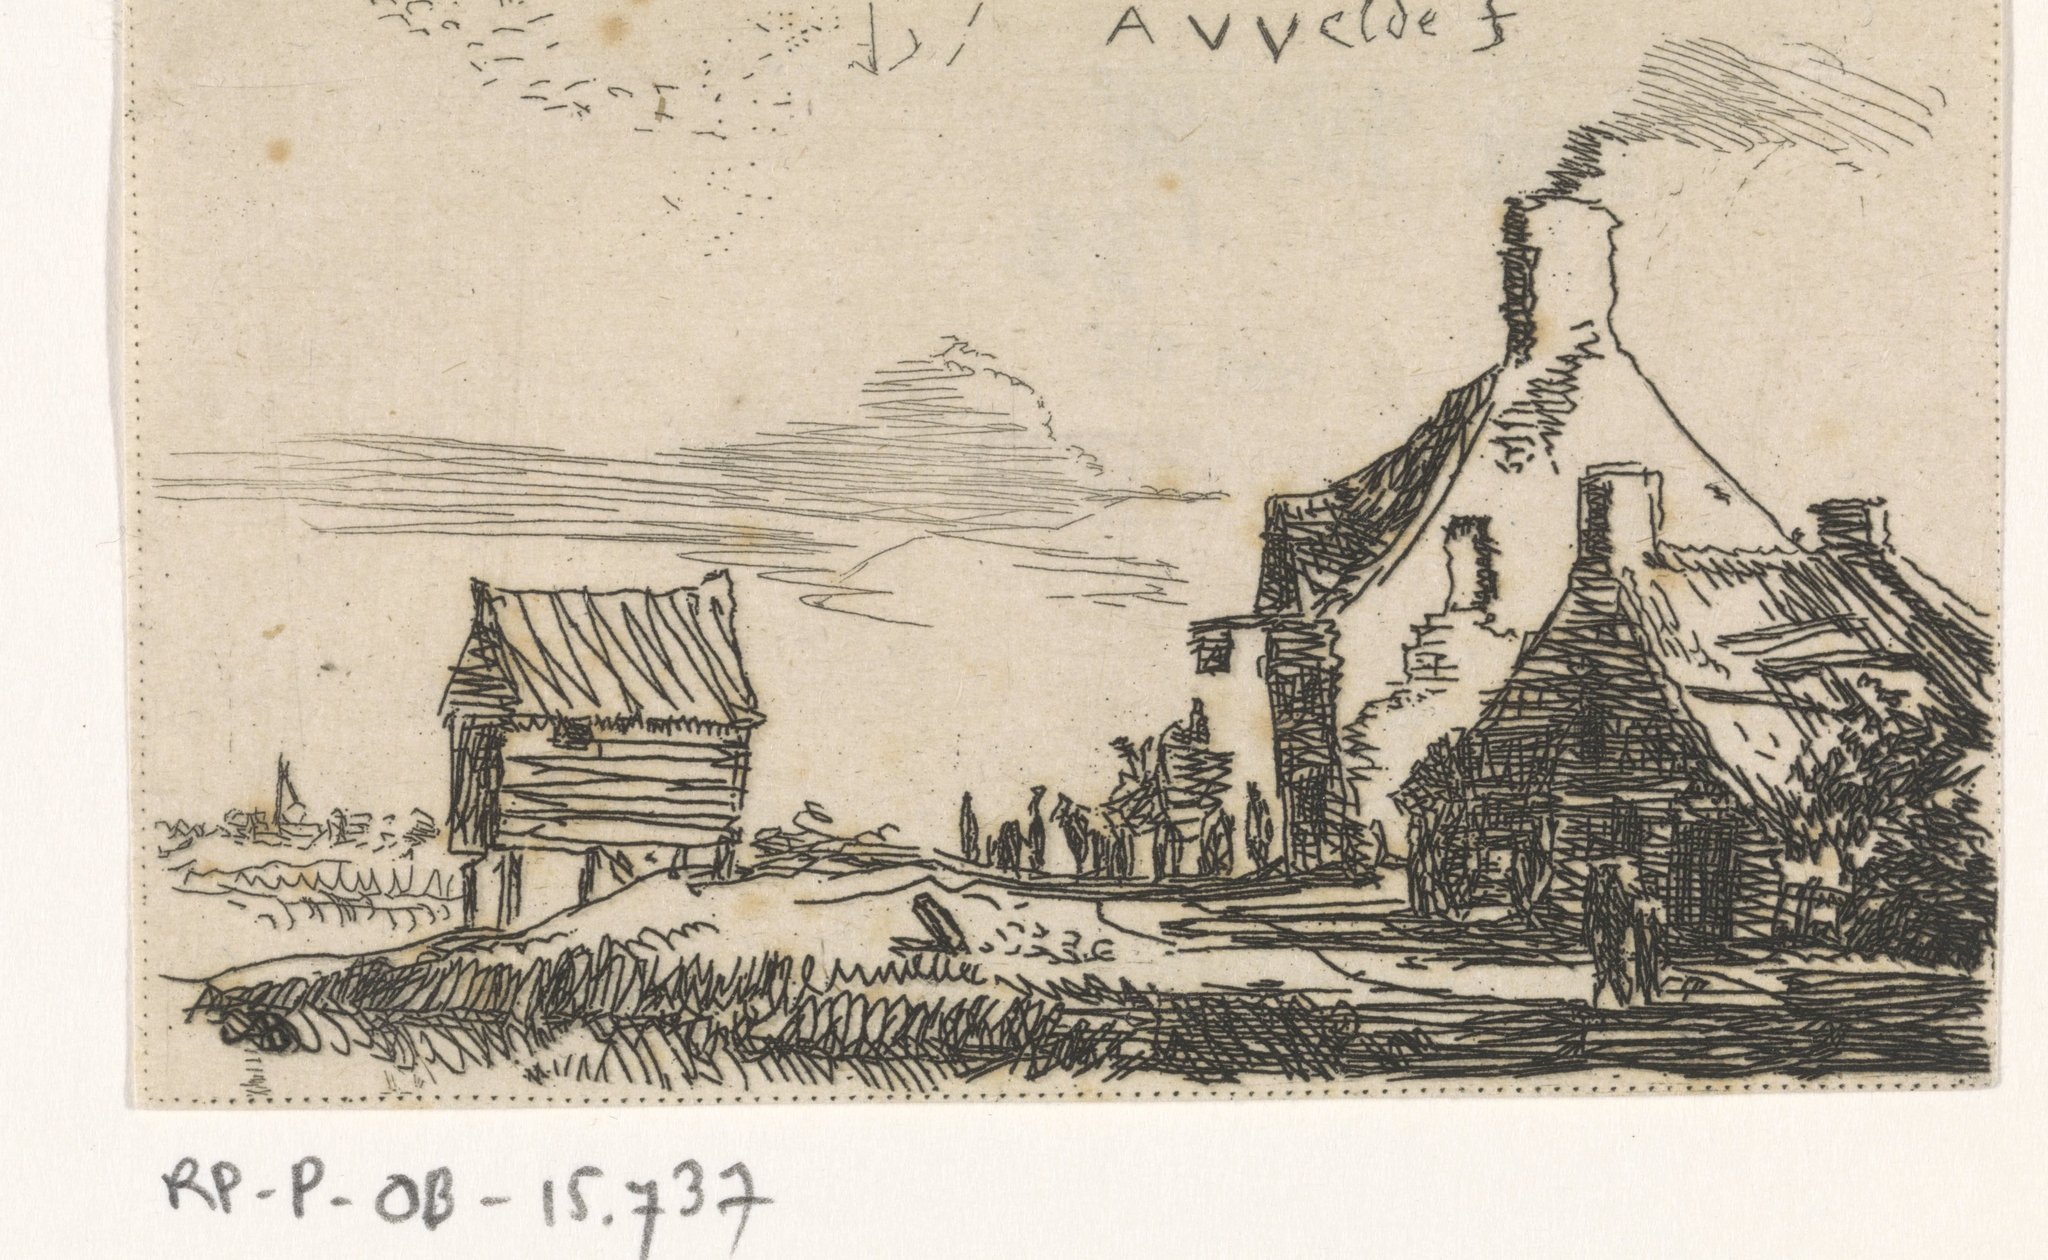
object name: print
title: Landschap met een wagen bij een herberg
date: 1650-1700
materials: paper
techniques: drypoint, etching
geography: northern netherlands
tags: chimney, hotel, hostelry, inn, (farm) wagon, freight wagon, cart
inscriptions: collector's mark: ‘W.G.F.’, collector's mark: Lugt 2228